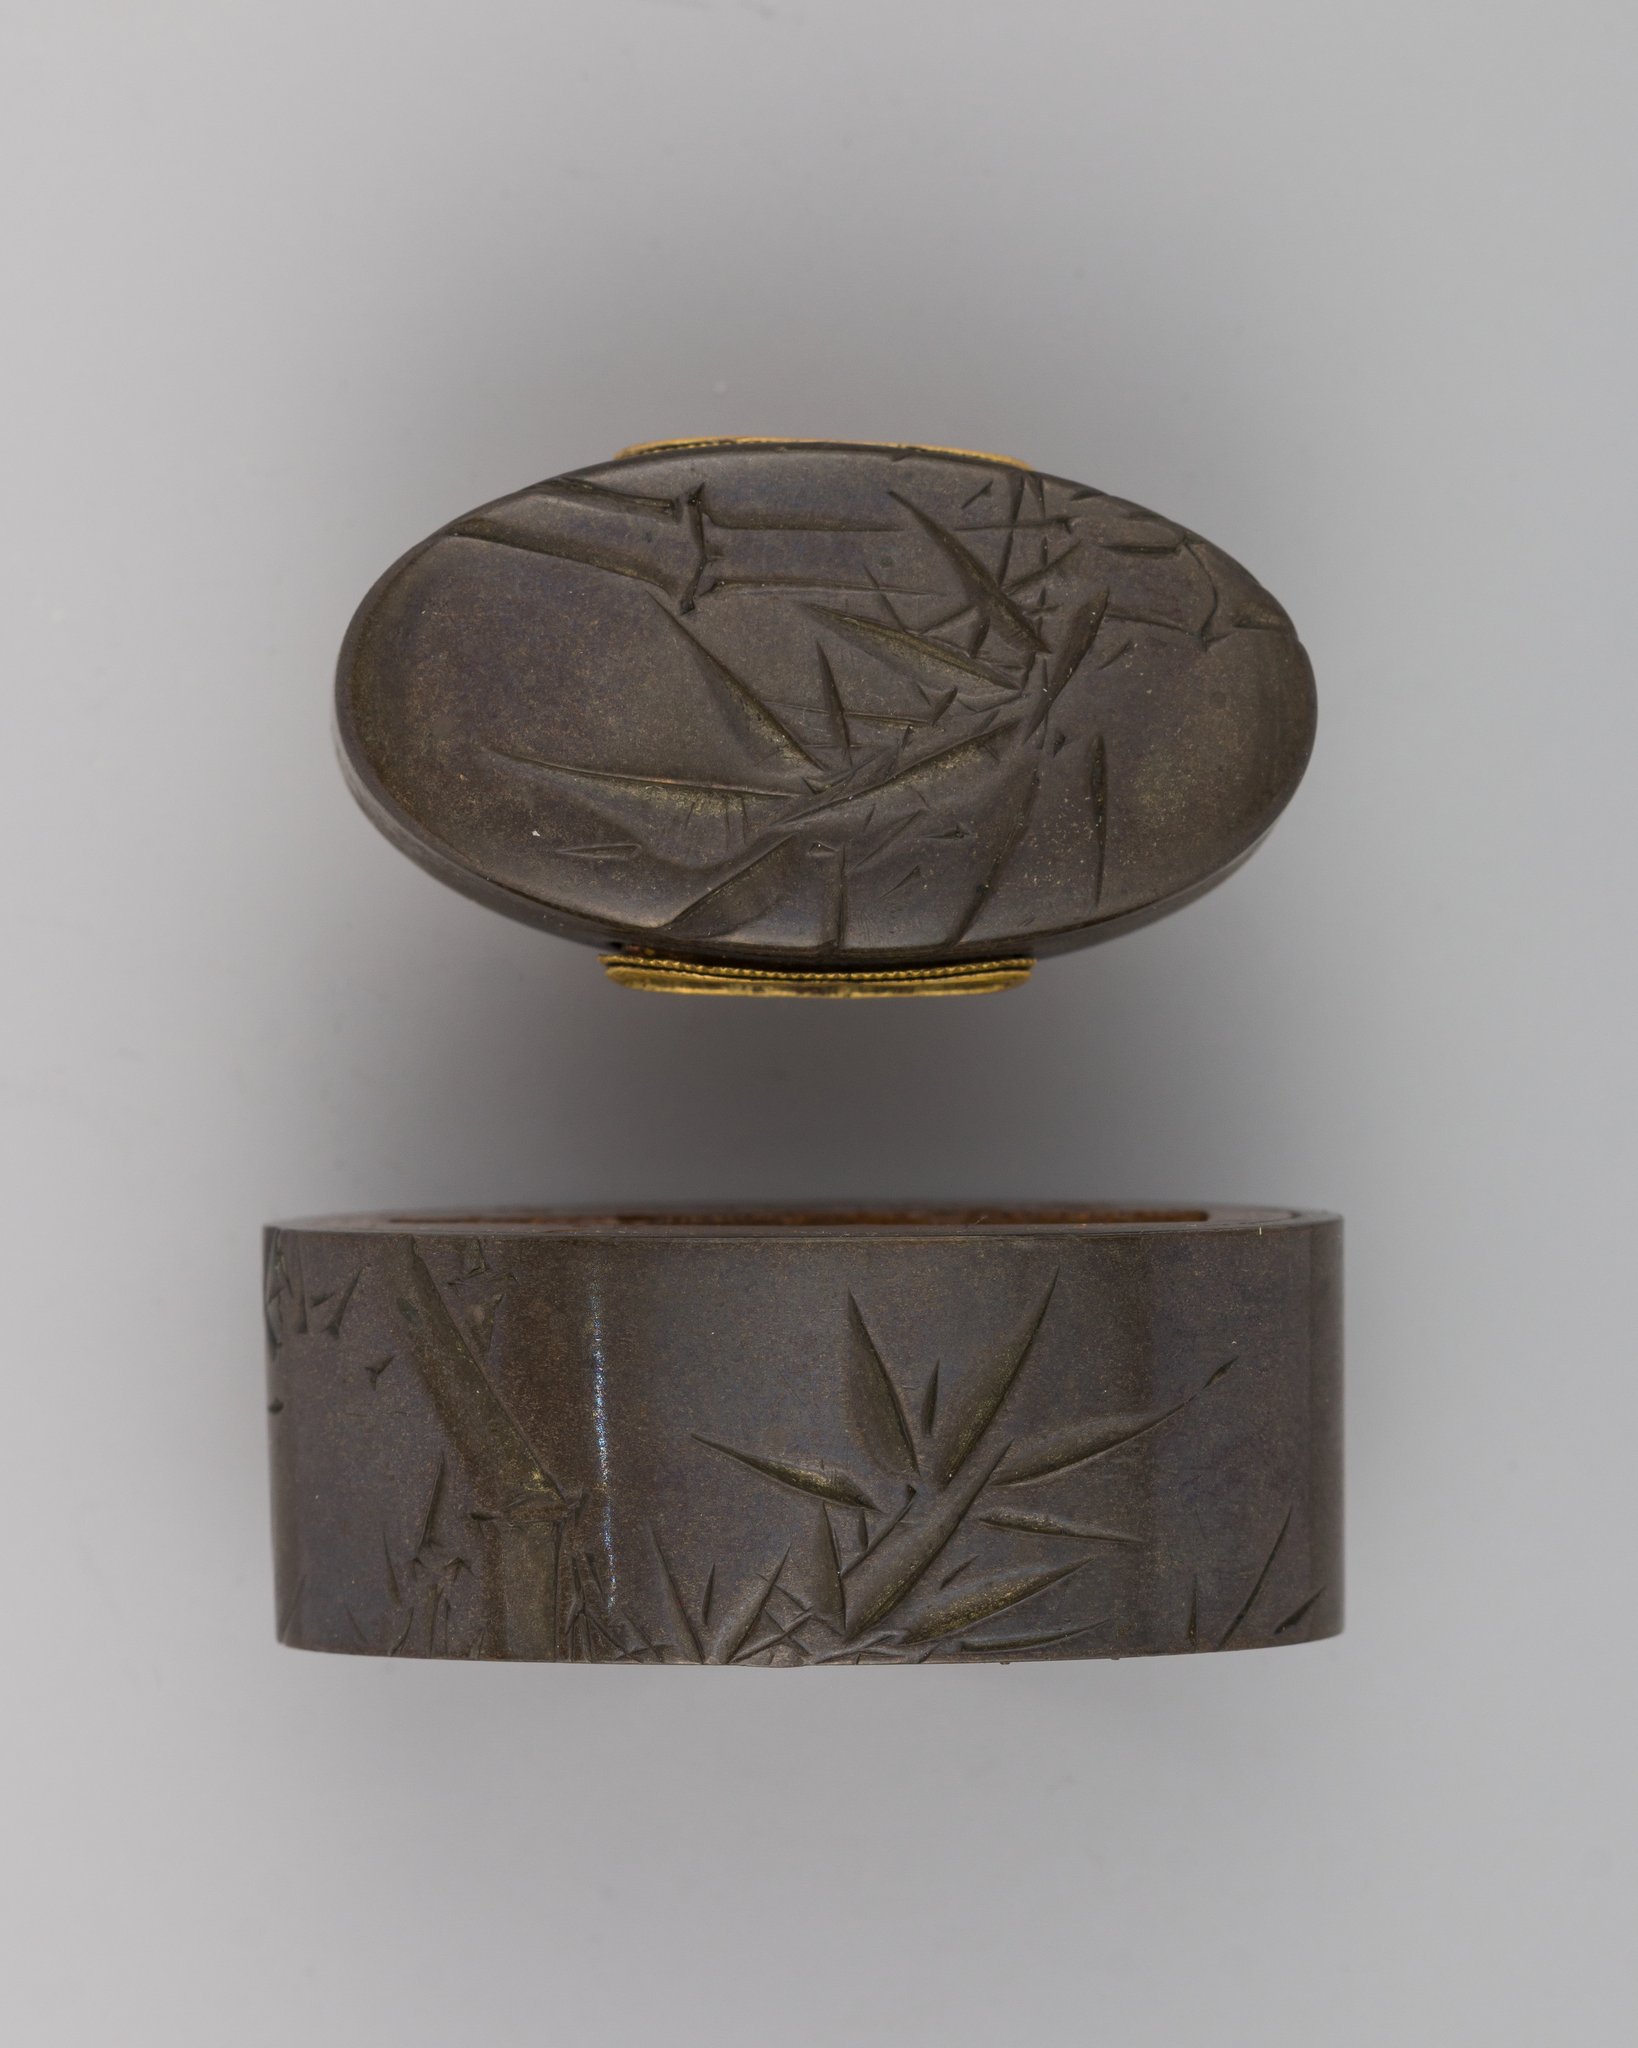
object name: sword hilt collar and pommel fuchigashira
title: Sword-Hilt Collar and Pommel (Fuchigashira)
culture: japanese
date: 1801-1900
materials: silver alloy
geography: japan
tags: leaves